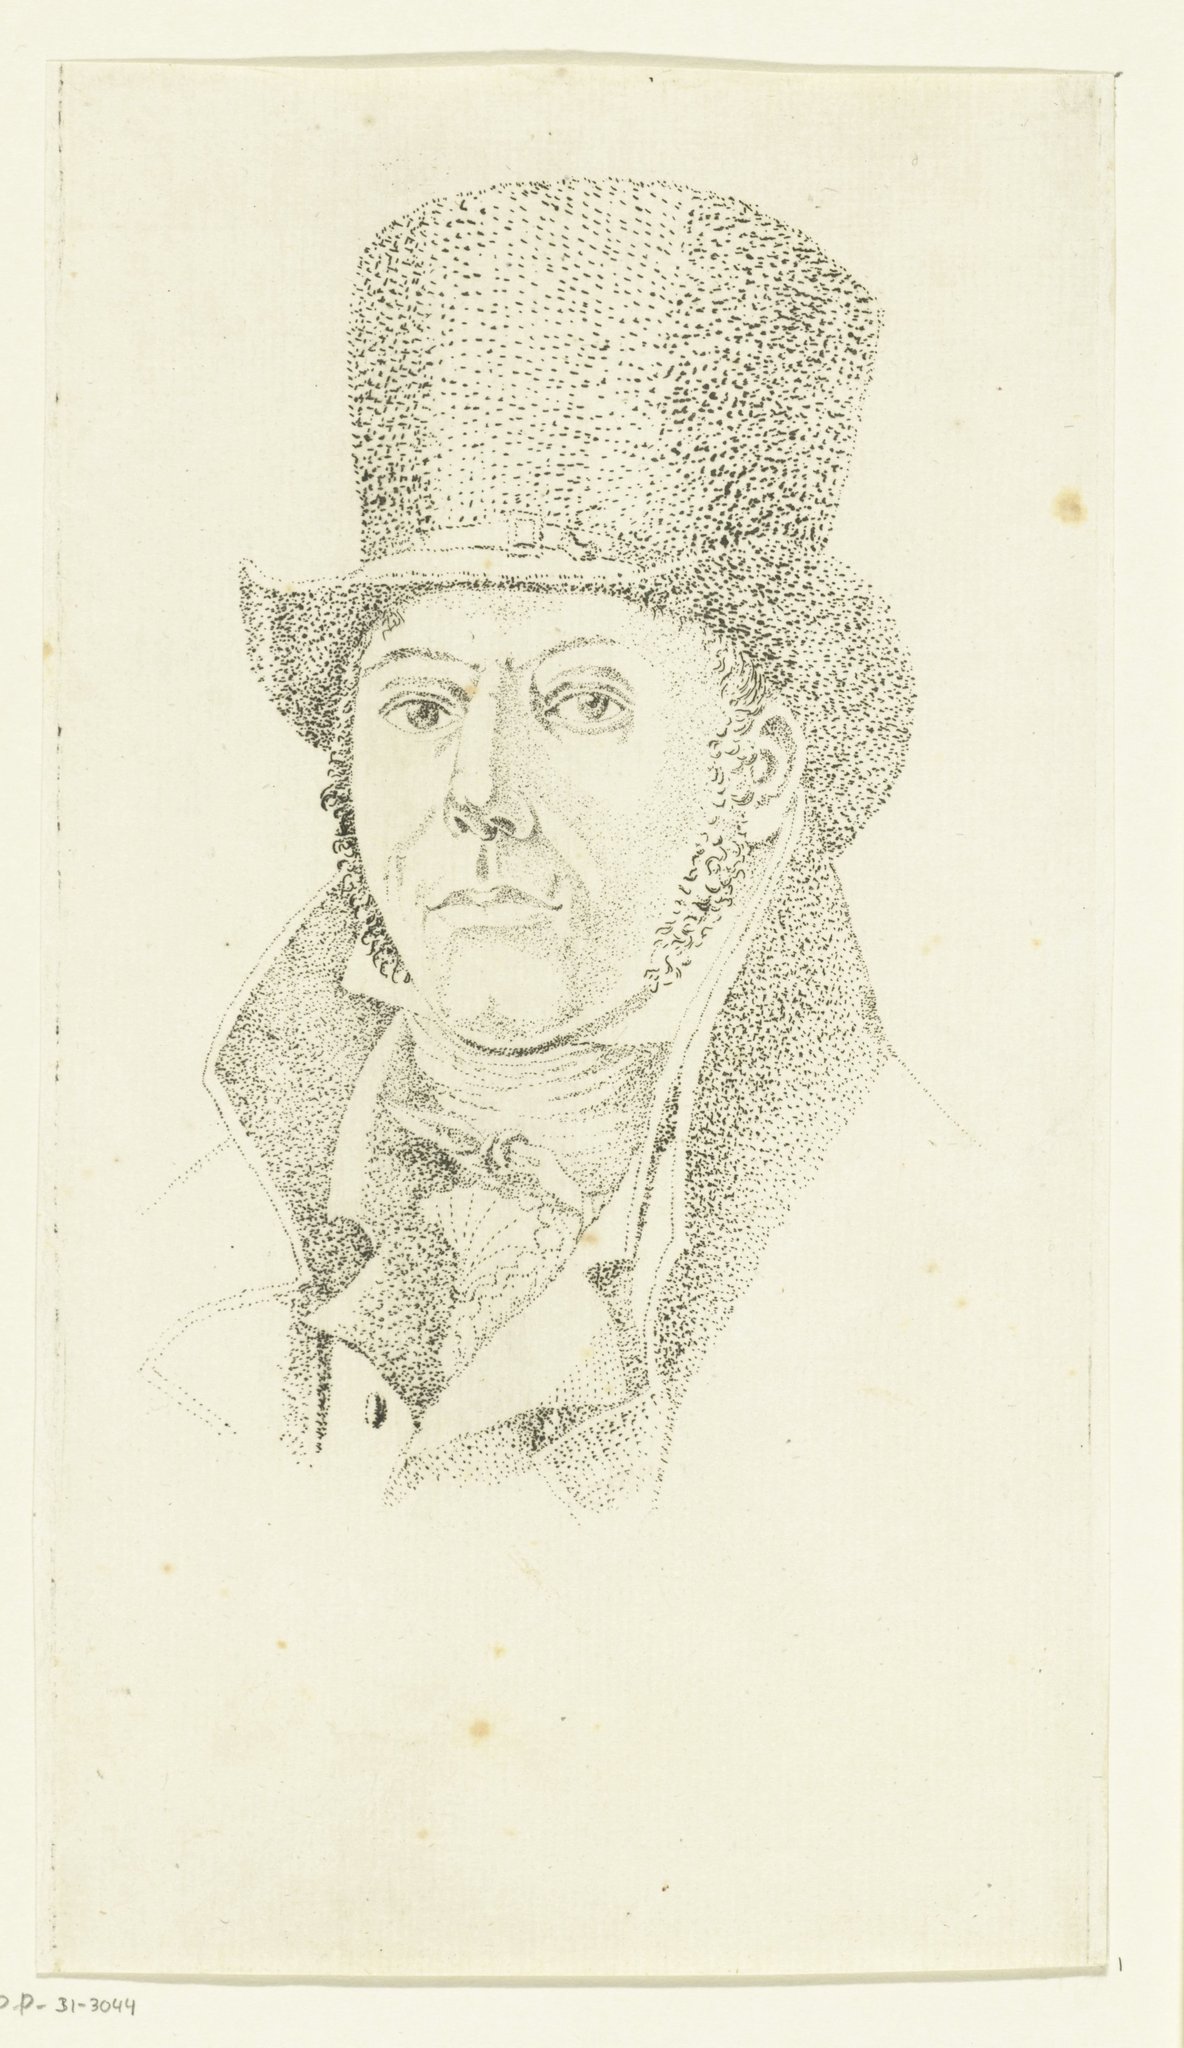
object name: print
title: Portret van Jacob Ernst Marcus met hoge hoed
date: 1805-1838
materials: paper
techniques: aquatint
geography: netherlands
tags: amsterdam, print maker, draughtsman, jacob ernst marcus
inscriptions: collector's mark: Lugt 2228